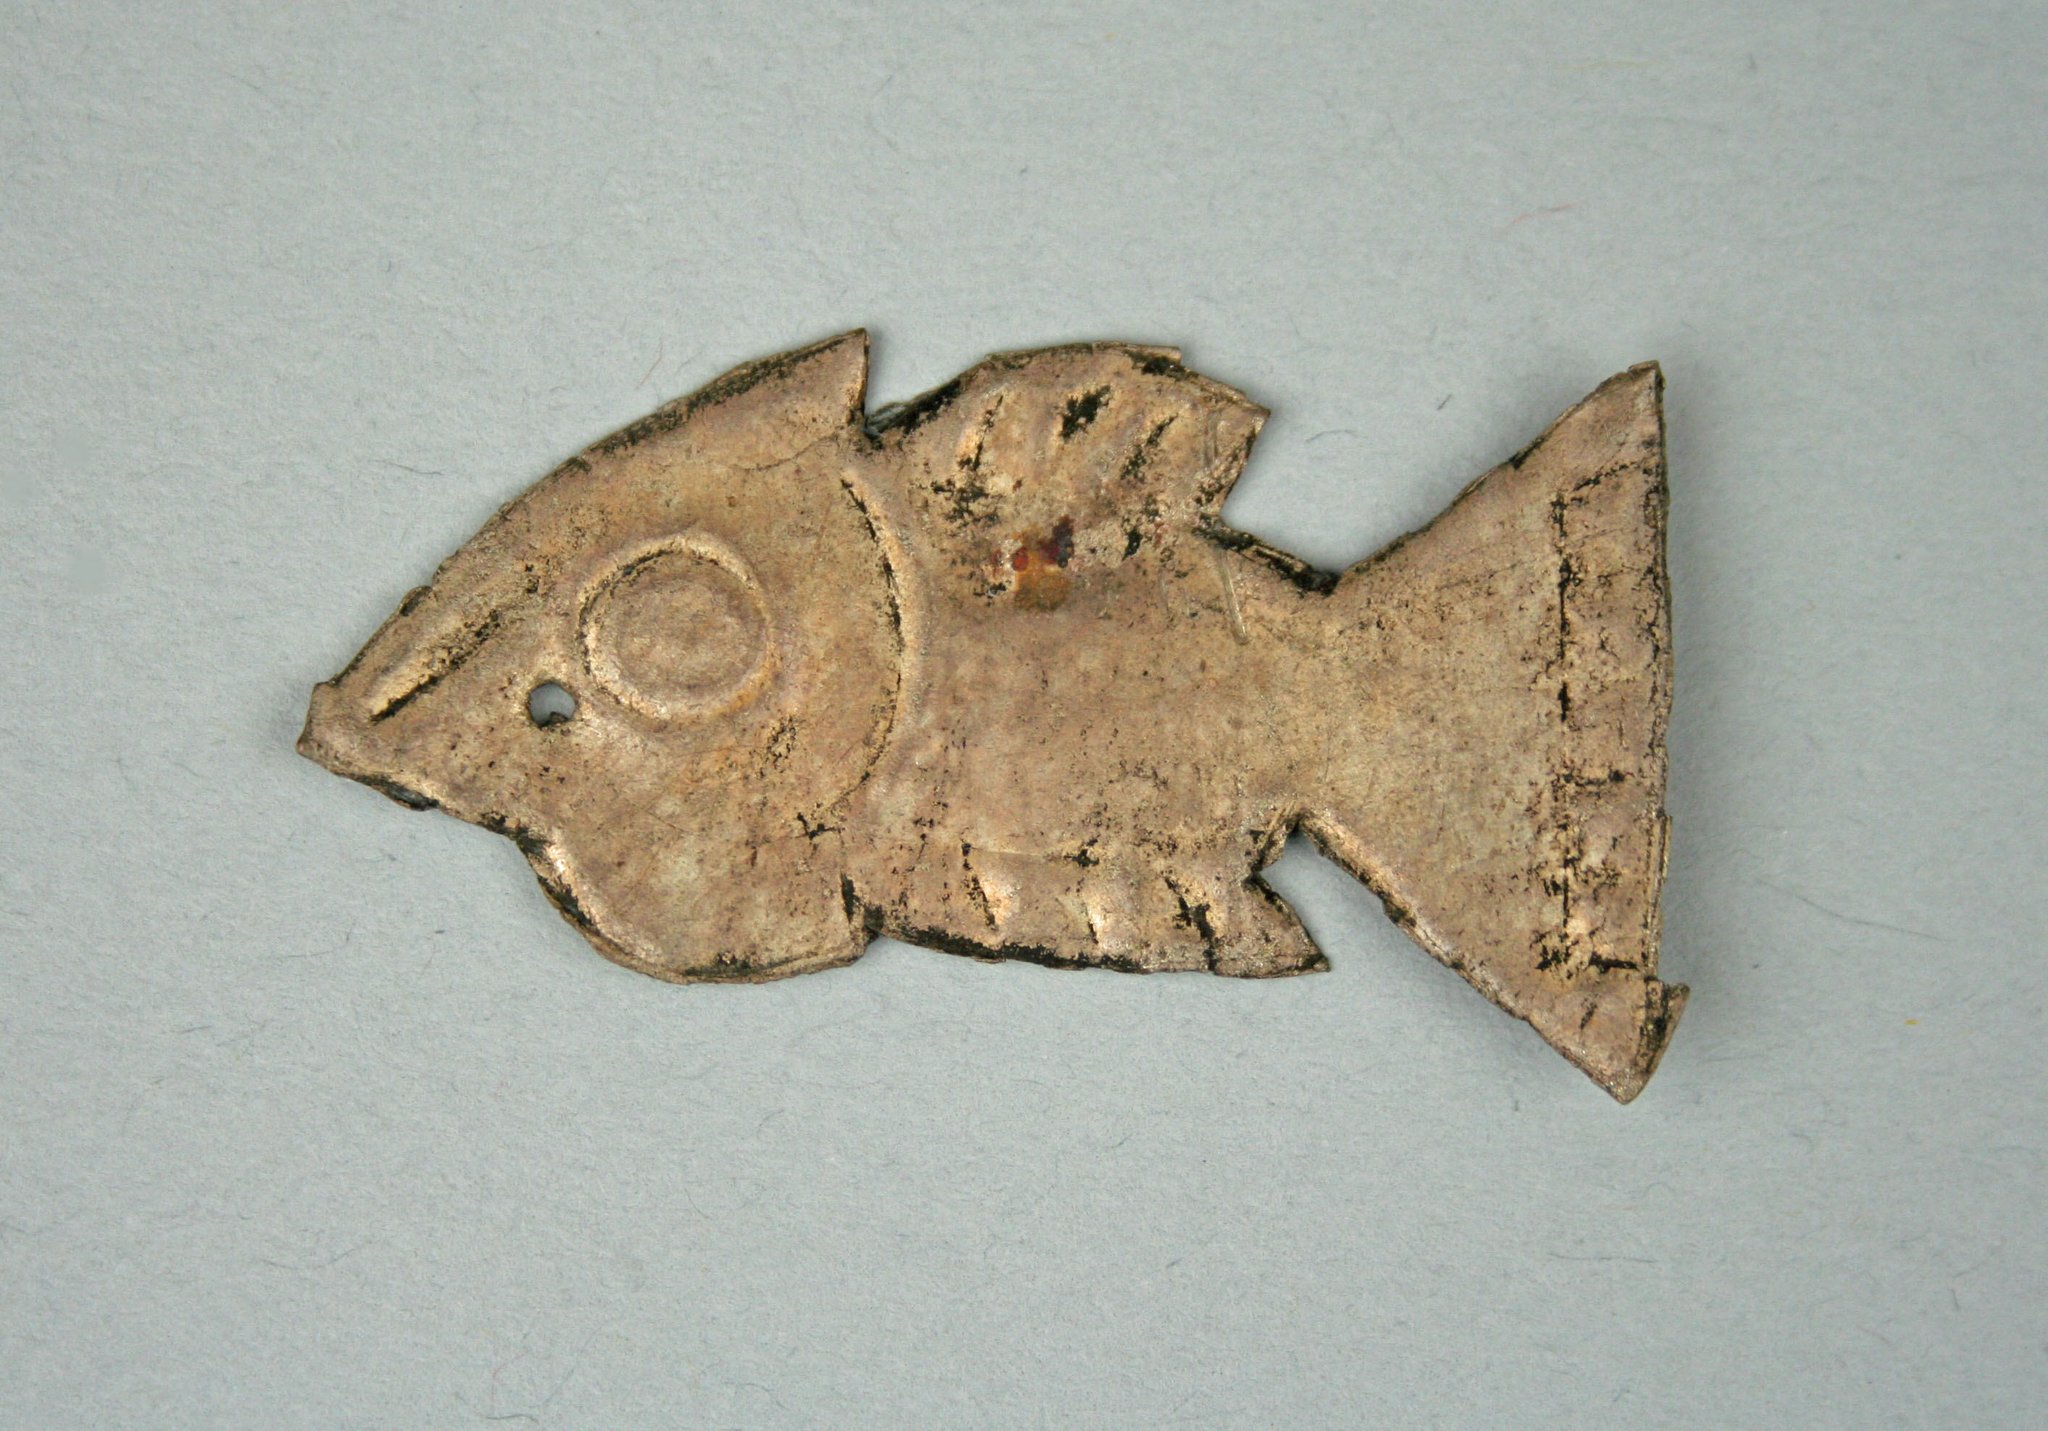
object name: ornament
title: Fish Ornament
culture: peruvian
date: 1001-1200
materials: silver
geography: peru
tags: fish